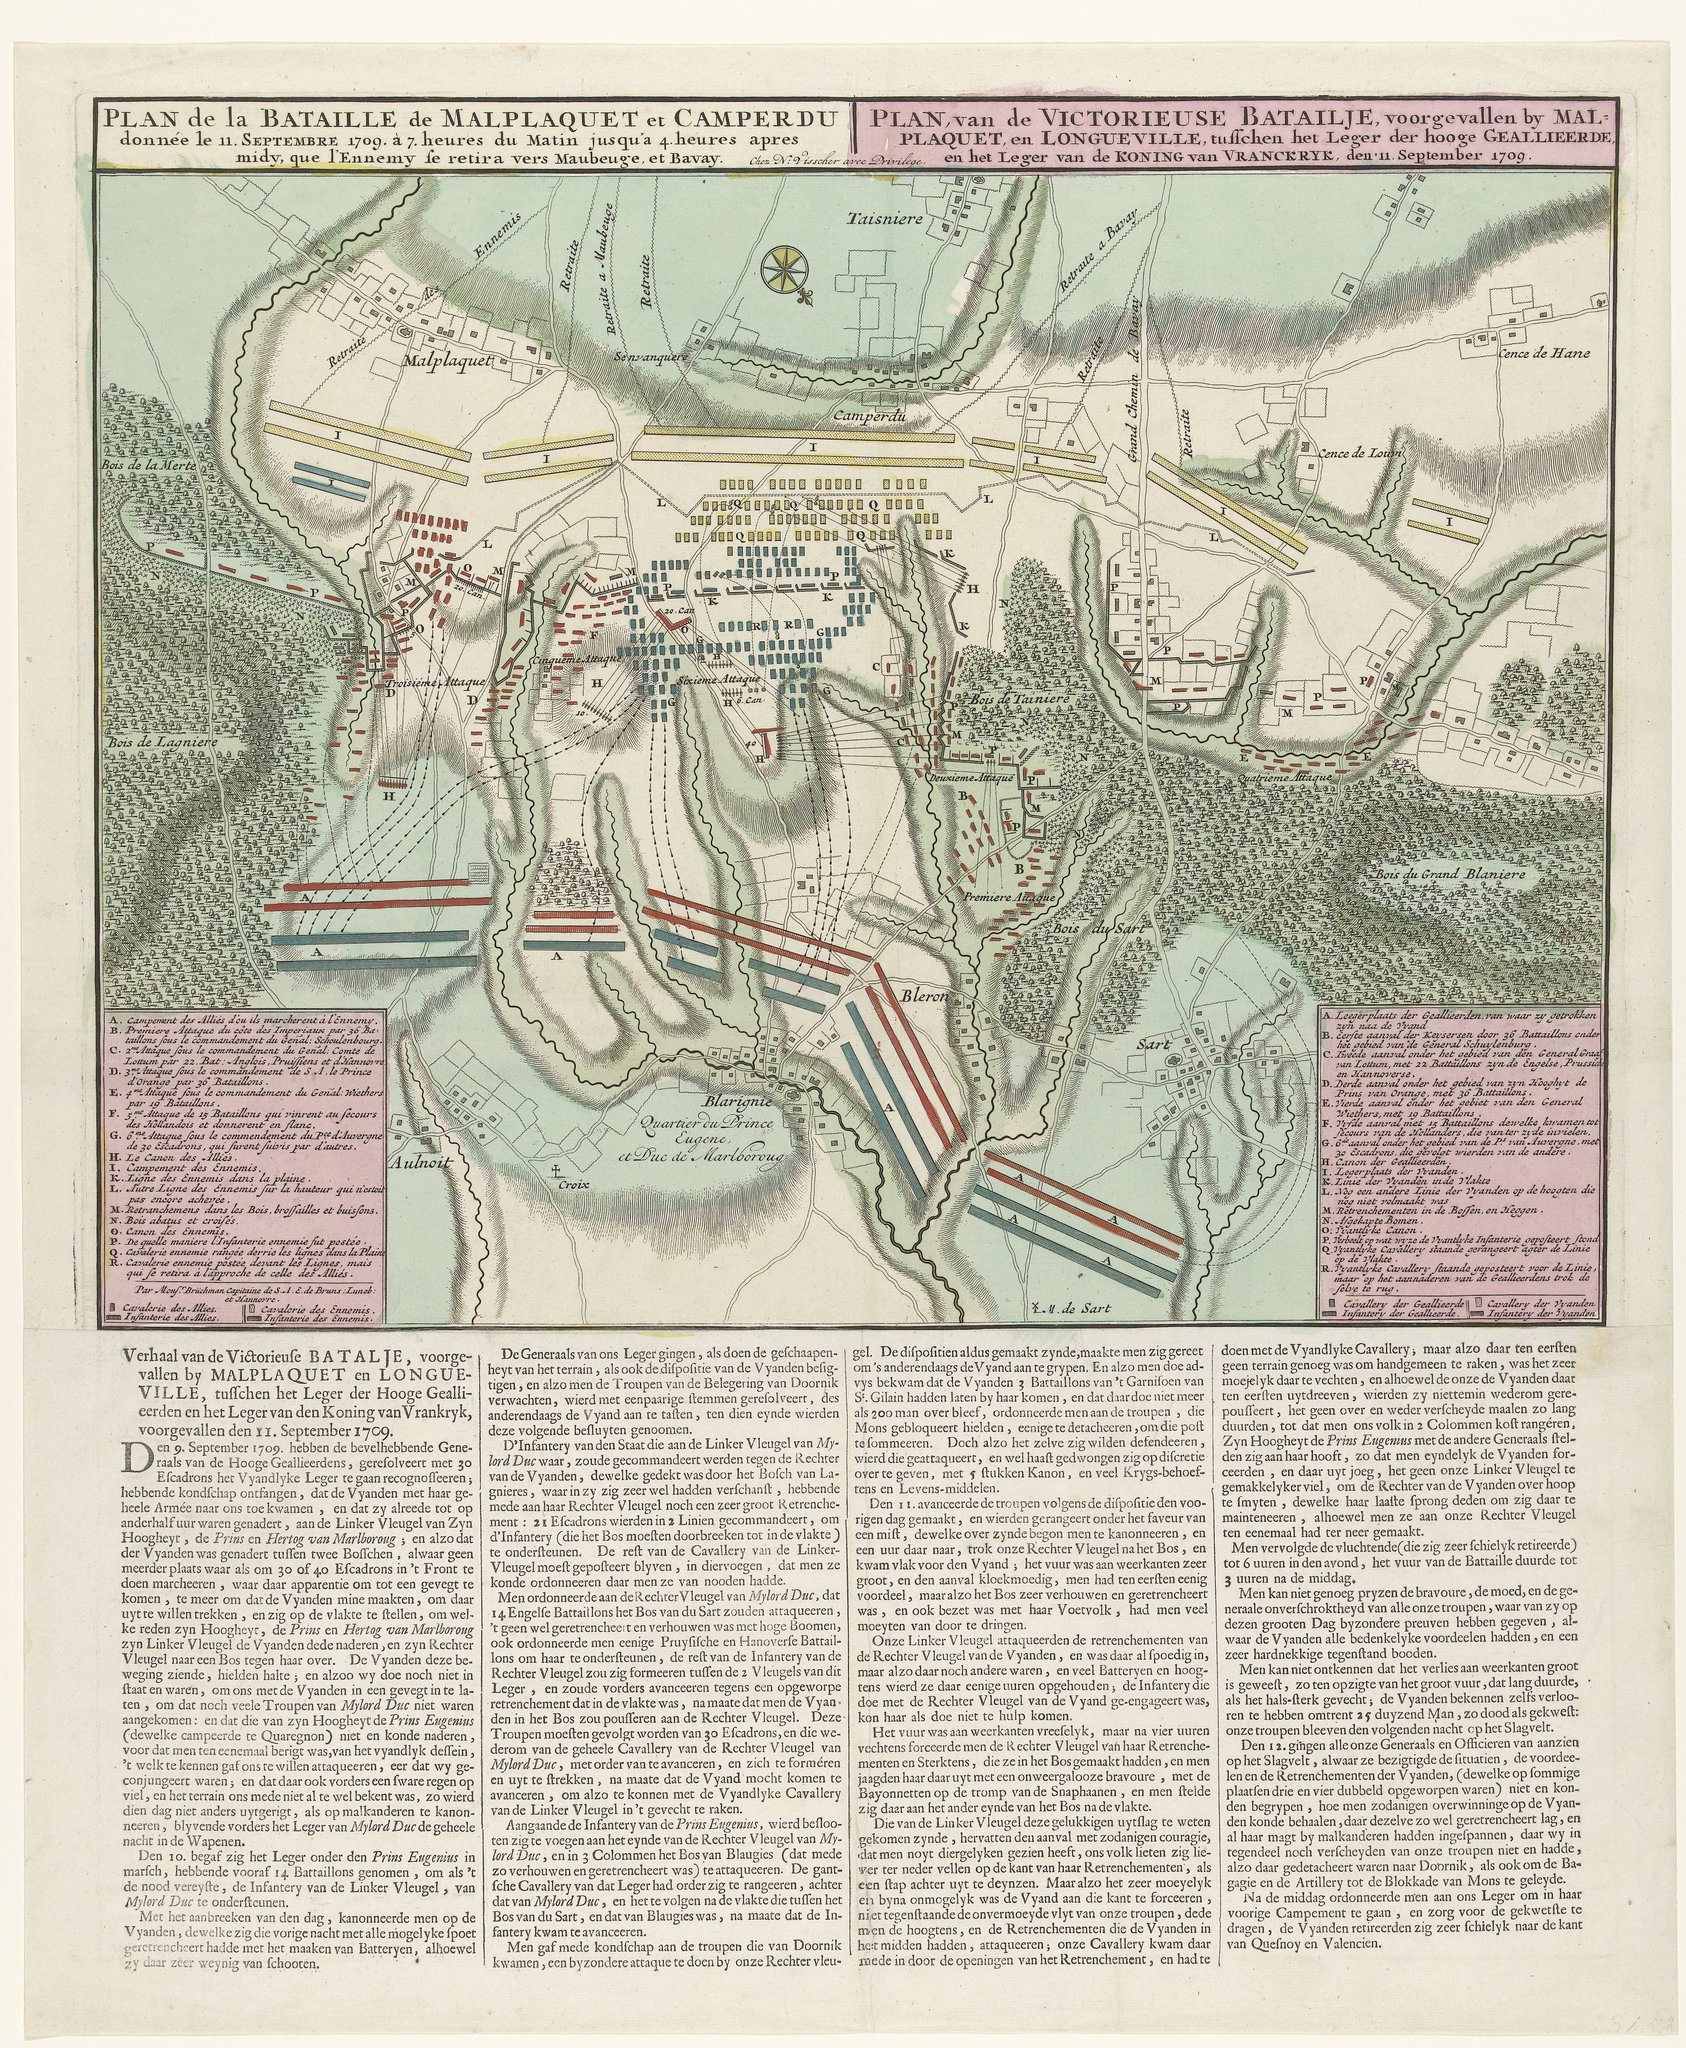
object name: print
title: Plan de la Bataille de Malplaquet et Camperdu donnée le 11. Septembre 1709. à 7. heures du Marin jusqu'a 4. heures apres midy, que l'Ennemy se retira vers Maubeuge, et Bavay / Plan, van de Victorieuse Batailje, voorgevallen by Malplaquet, en Longueville, tusschen het Leger der hooge Geallieerde, en het Leger van de Koning van Vranckryk, den 11. September 1709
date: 1709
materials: paper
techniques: etching, hand coloring, letterpress printing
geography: northern netherlands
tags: maps of separate countries or regions, battle (+ land forces)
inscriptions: collector's mark: Lugt 2228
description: Kaart van de slag bij Malplaquet tussen de Geallieerden en de Fransen, 11 september 1709. Onderaan de legenda's A-R in het Frans en Nederlands. Vastgeplakt onder de prent is een tekstblad met het verhaal van de slag in 4 kolommen in het Nederlands.